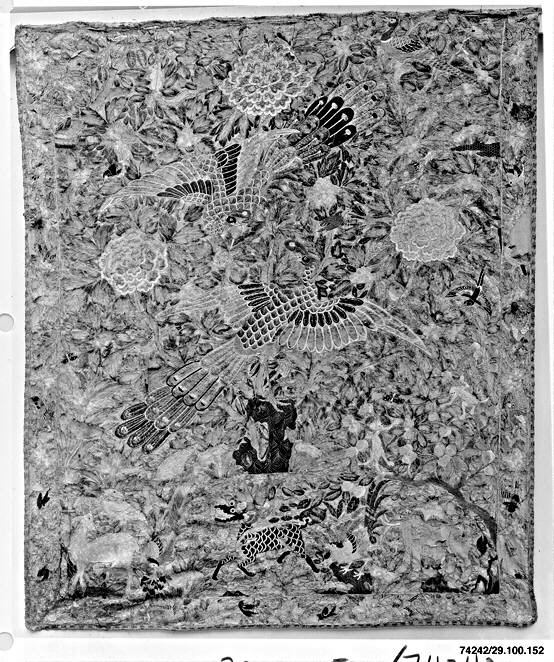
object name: panel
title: Vertical panel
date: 1501-1600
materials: metal thread, silk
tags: peacocks,flowers